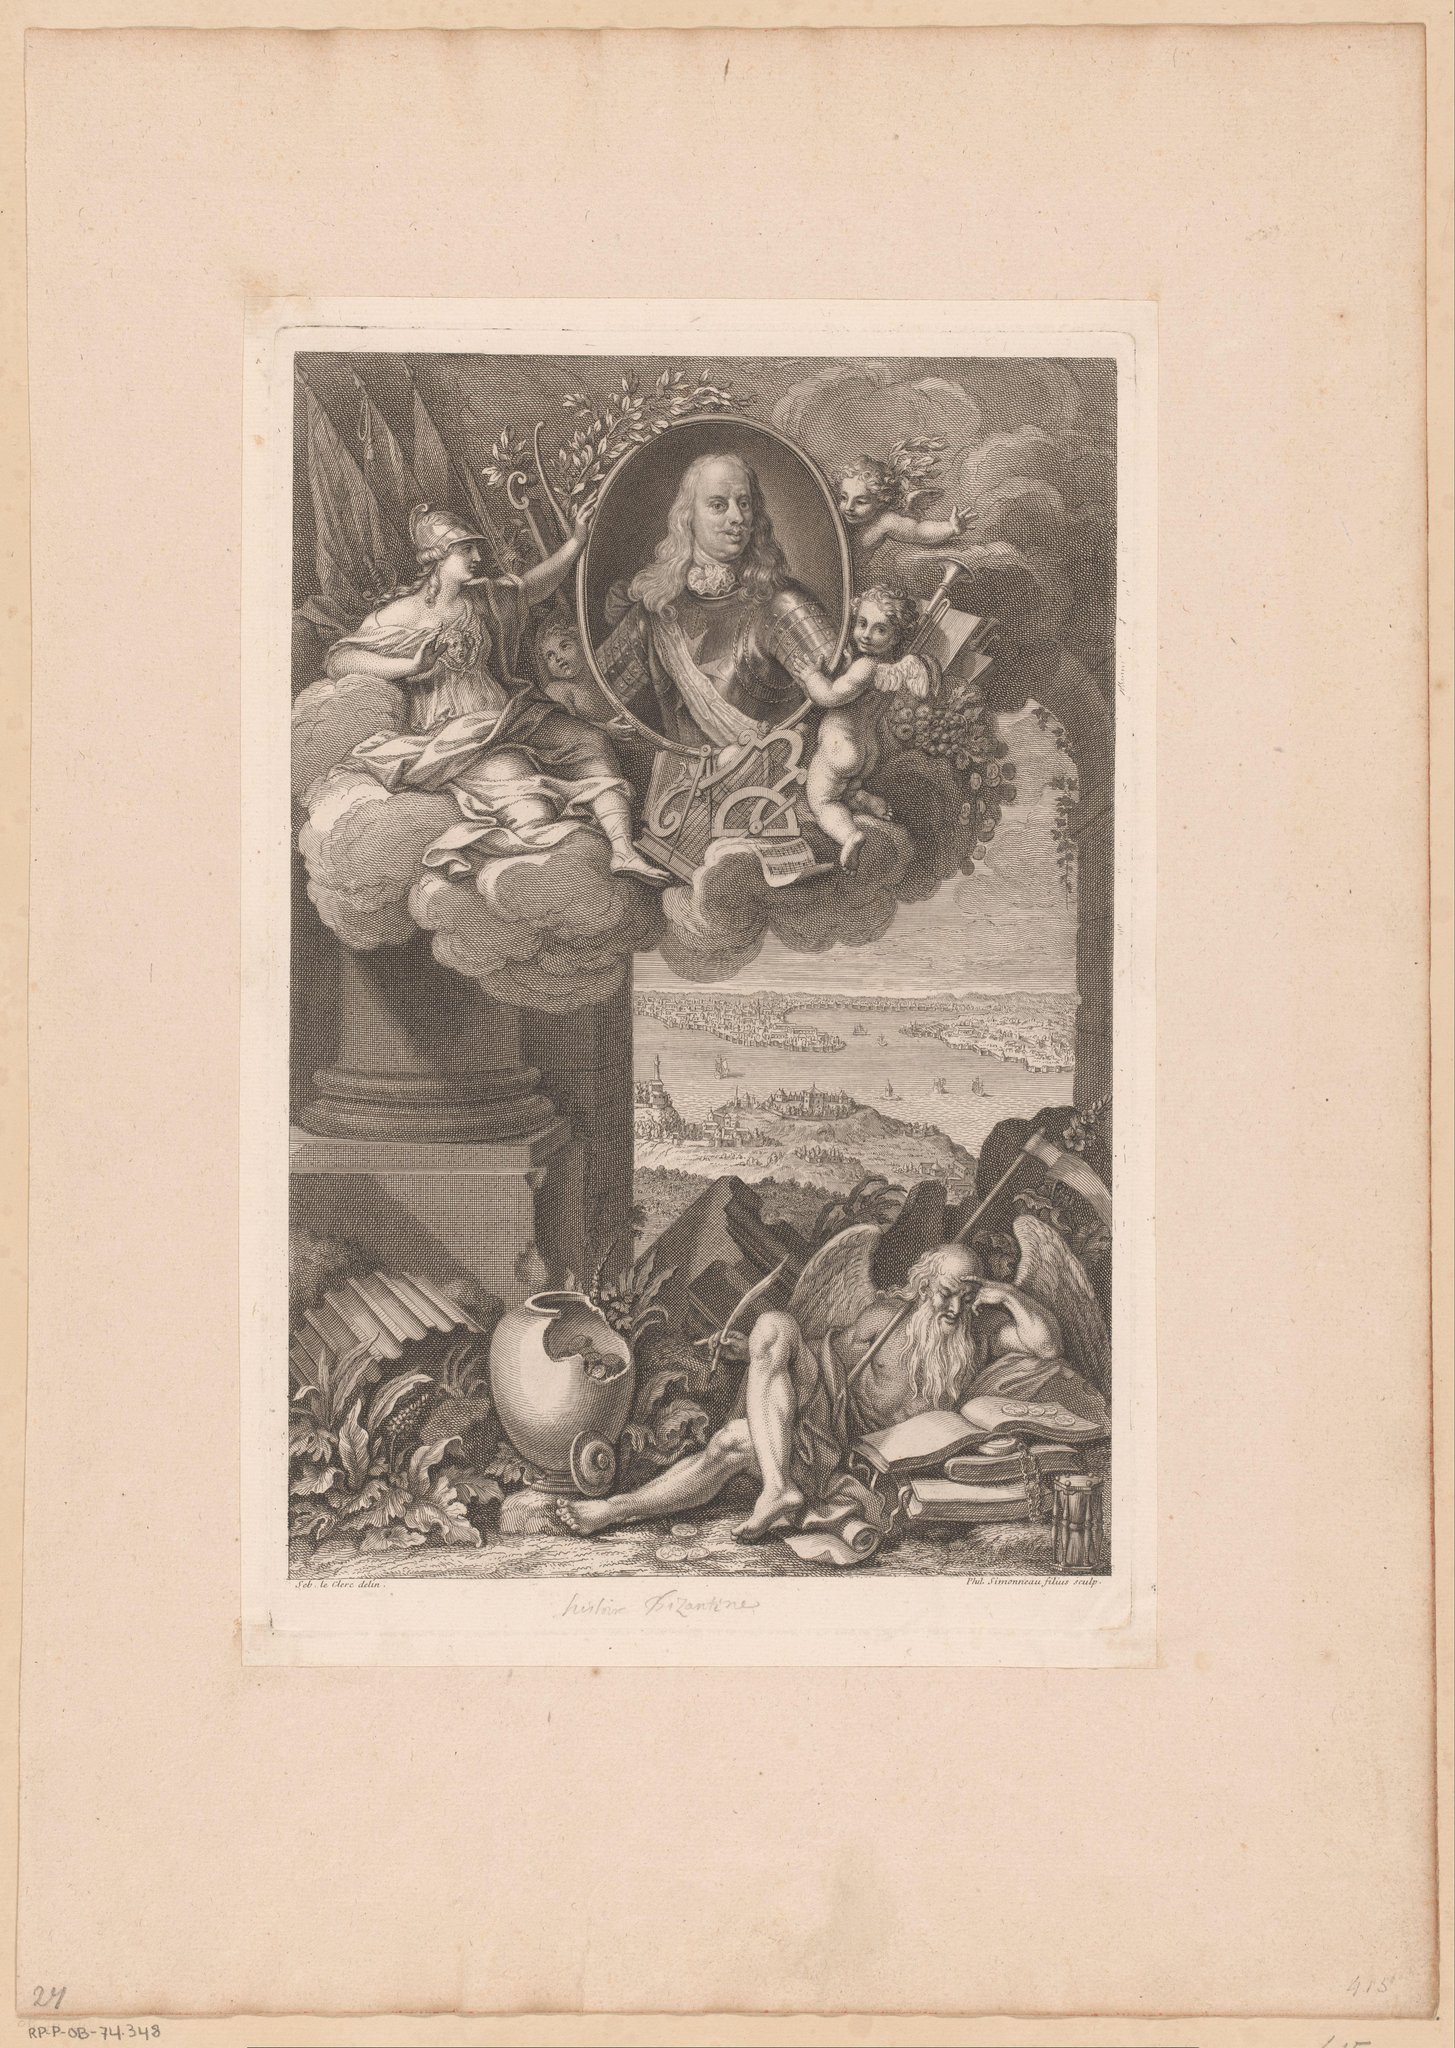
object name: print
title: Portret van veldheer opgehouden door Minerva en putti, boven de Tijd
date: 1695-1753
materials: paper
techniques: engraving, etching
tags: (story of) minerva (pallas, athena), historical persons, father time, man with wings and scythe